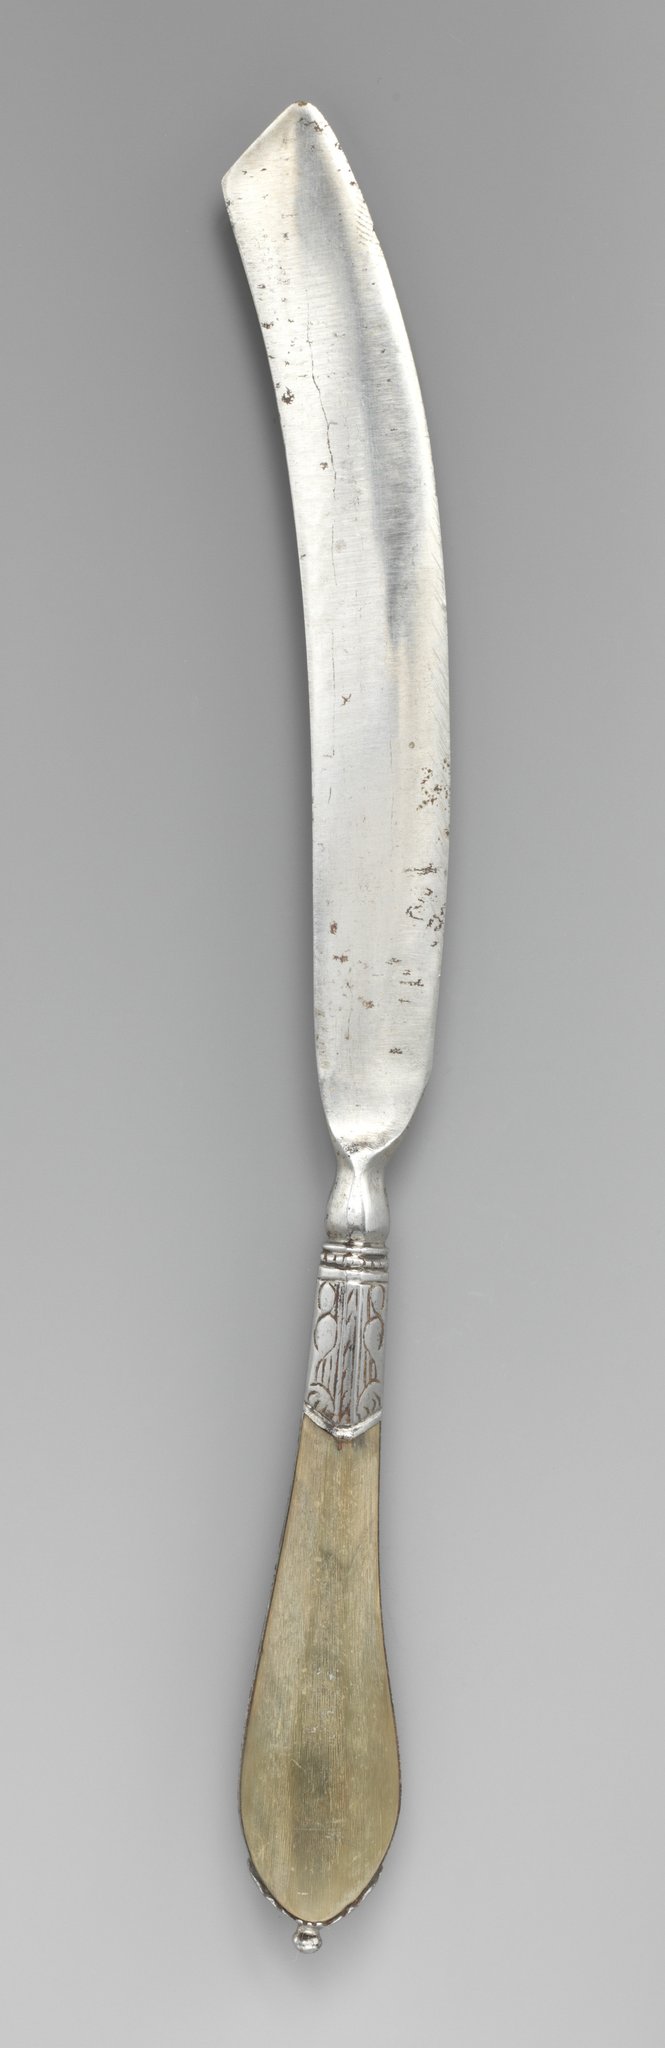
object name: table knife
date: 1701-1800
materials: horn, silver, steel